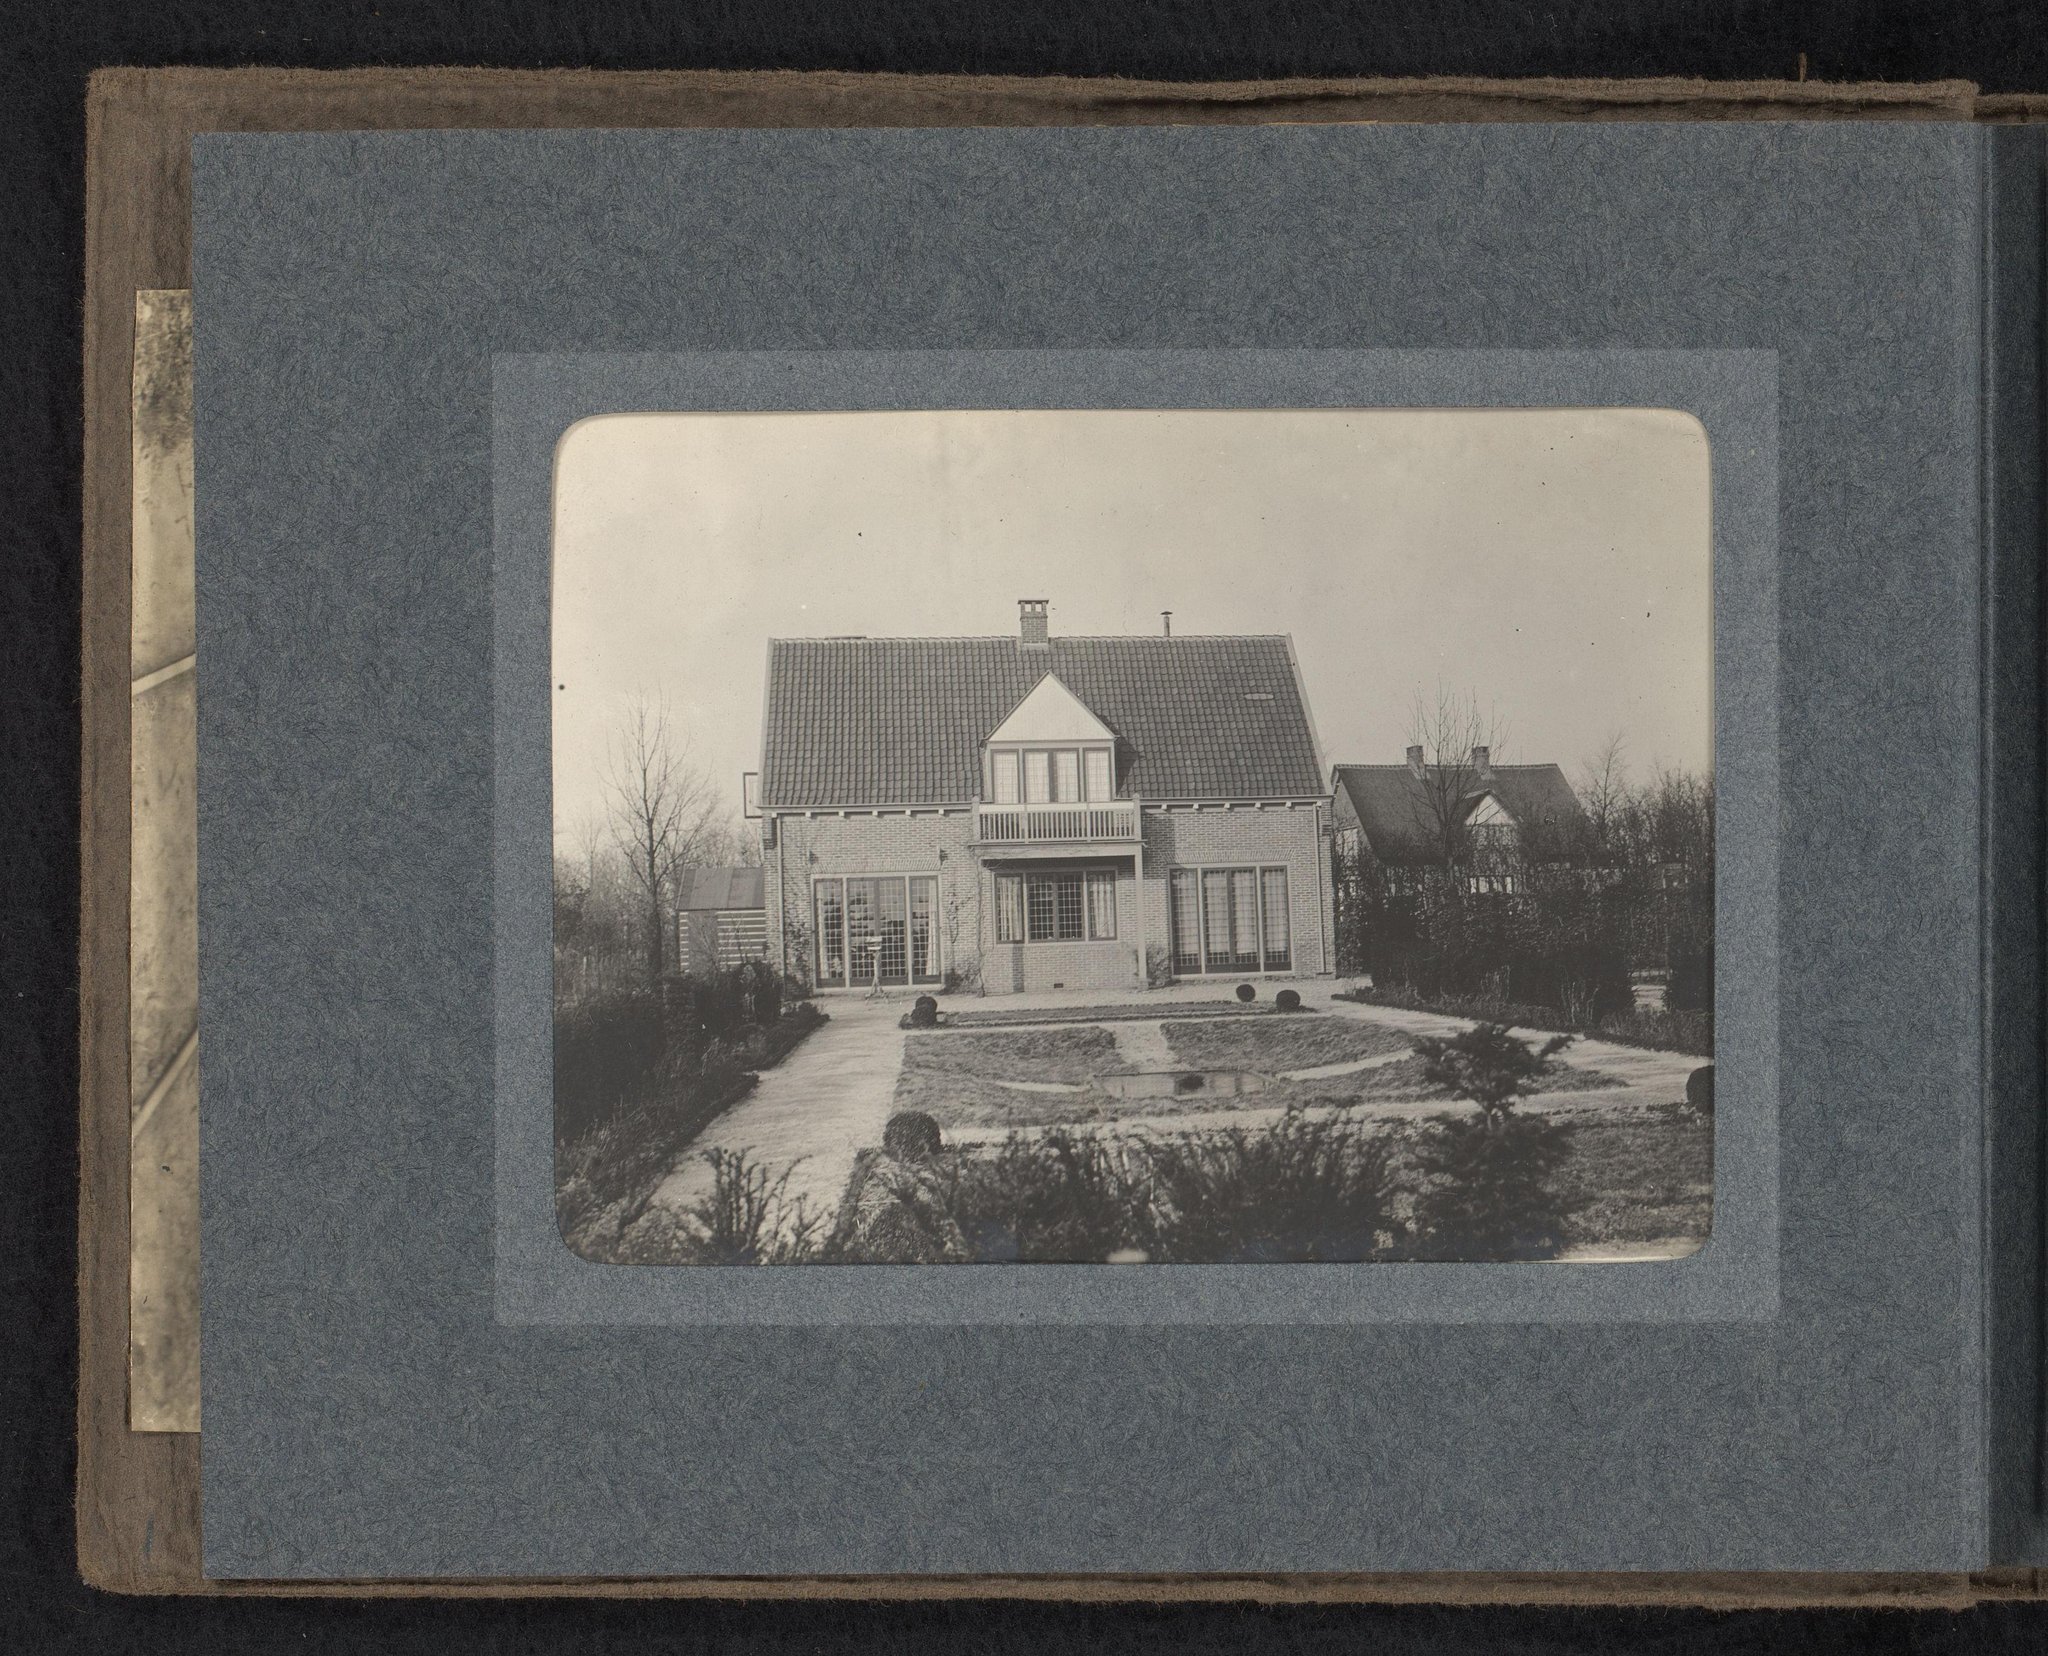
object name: photograph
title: Achterzijde van een huis in Blaricum, gezien vanuit de tuin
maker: hendrik herman van den berg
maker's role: amateurfotograaf, jurist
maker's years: 1875-1944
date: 1913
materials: paper, cardboard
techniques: gelatin silver print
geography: blaricum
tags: garden, village, villa